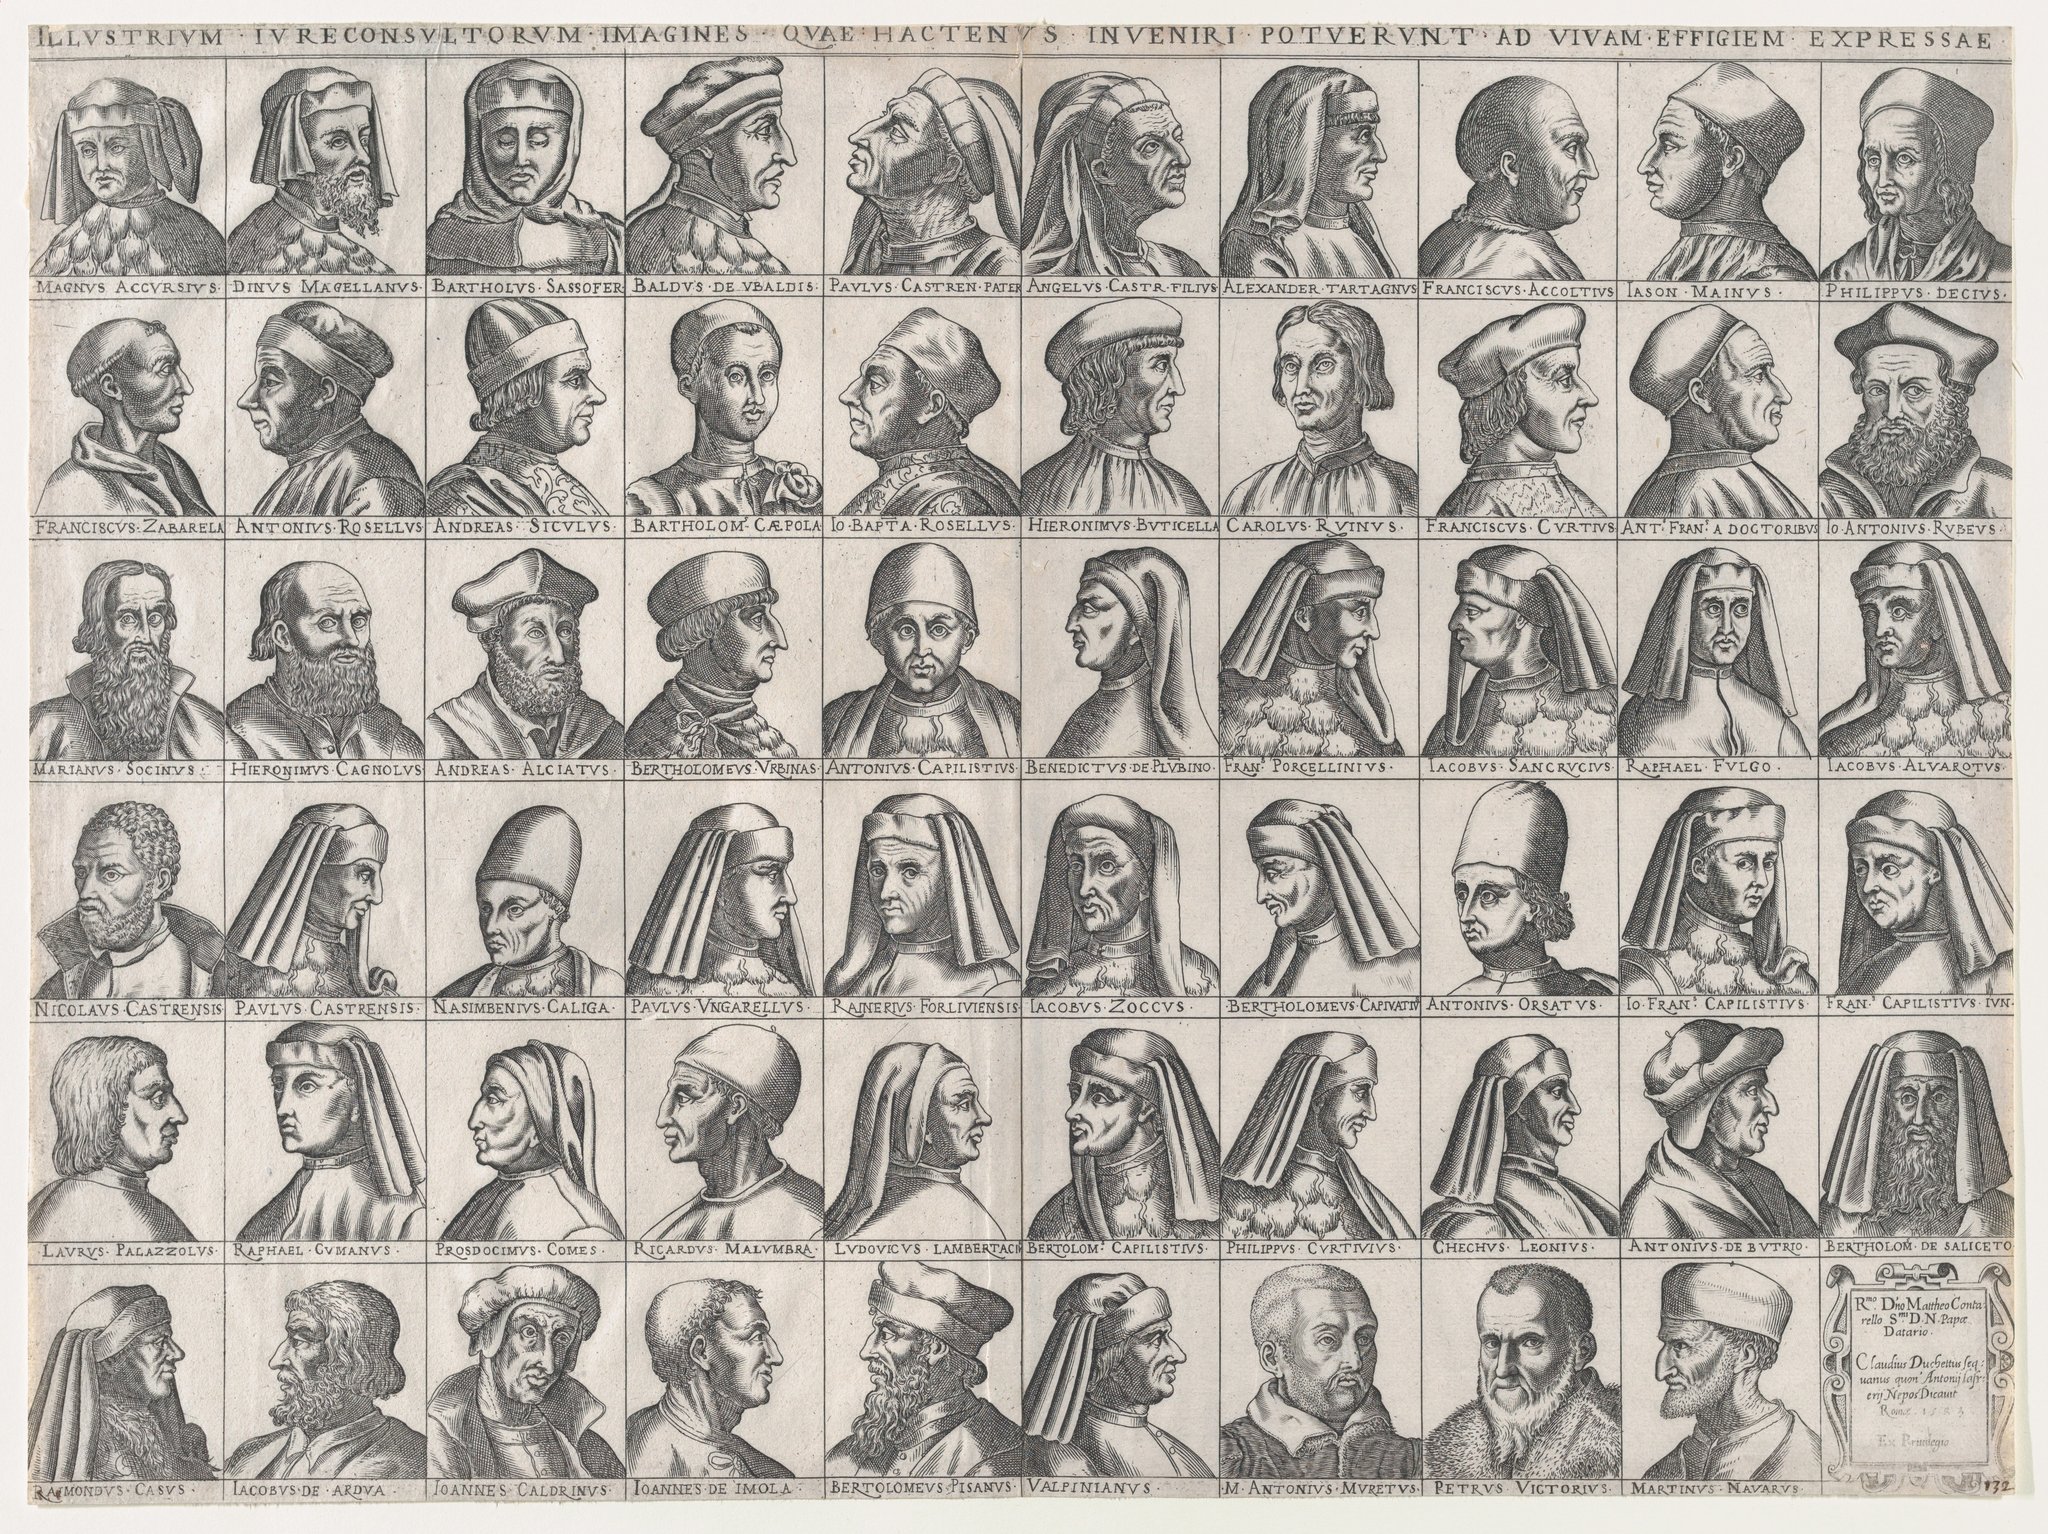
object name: print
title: Portraits of Roman Jurisconsults, from "Speculum Romanae Magnificentiae"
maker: Anonymous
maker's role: artist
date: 1583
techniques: engraving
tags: men,portraits,profiles,women